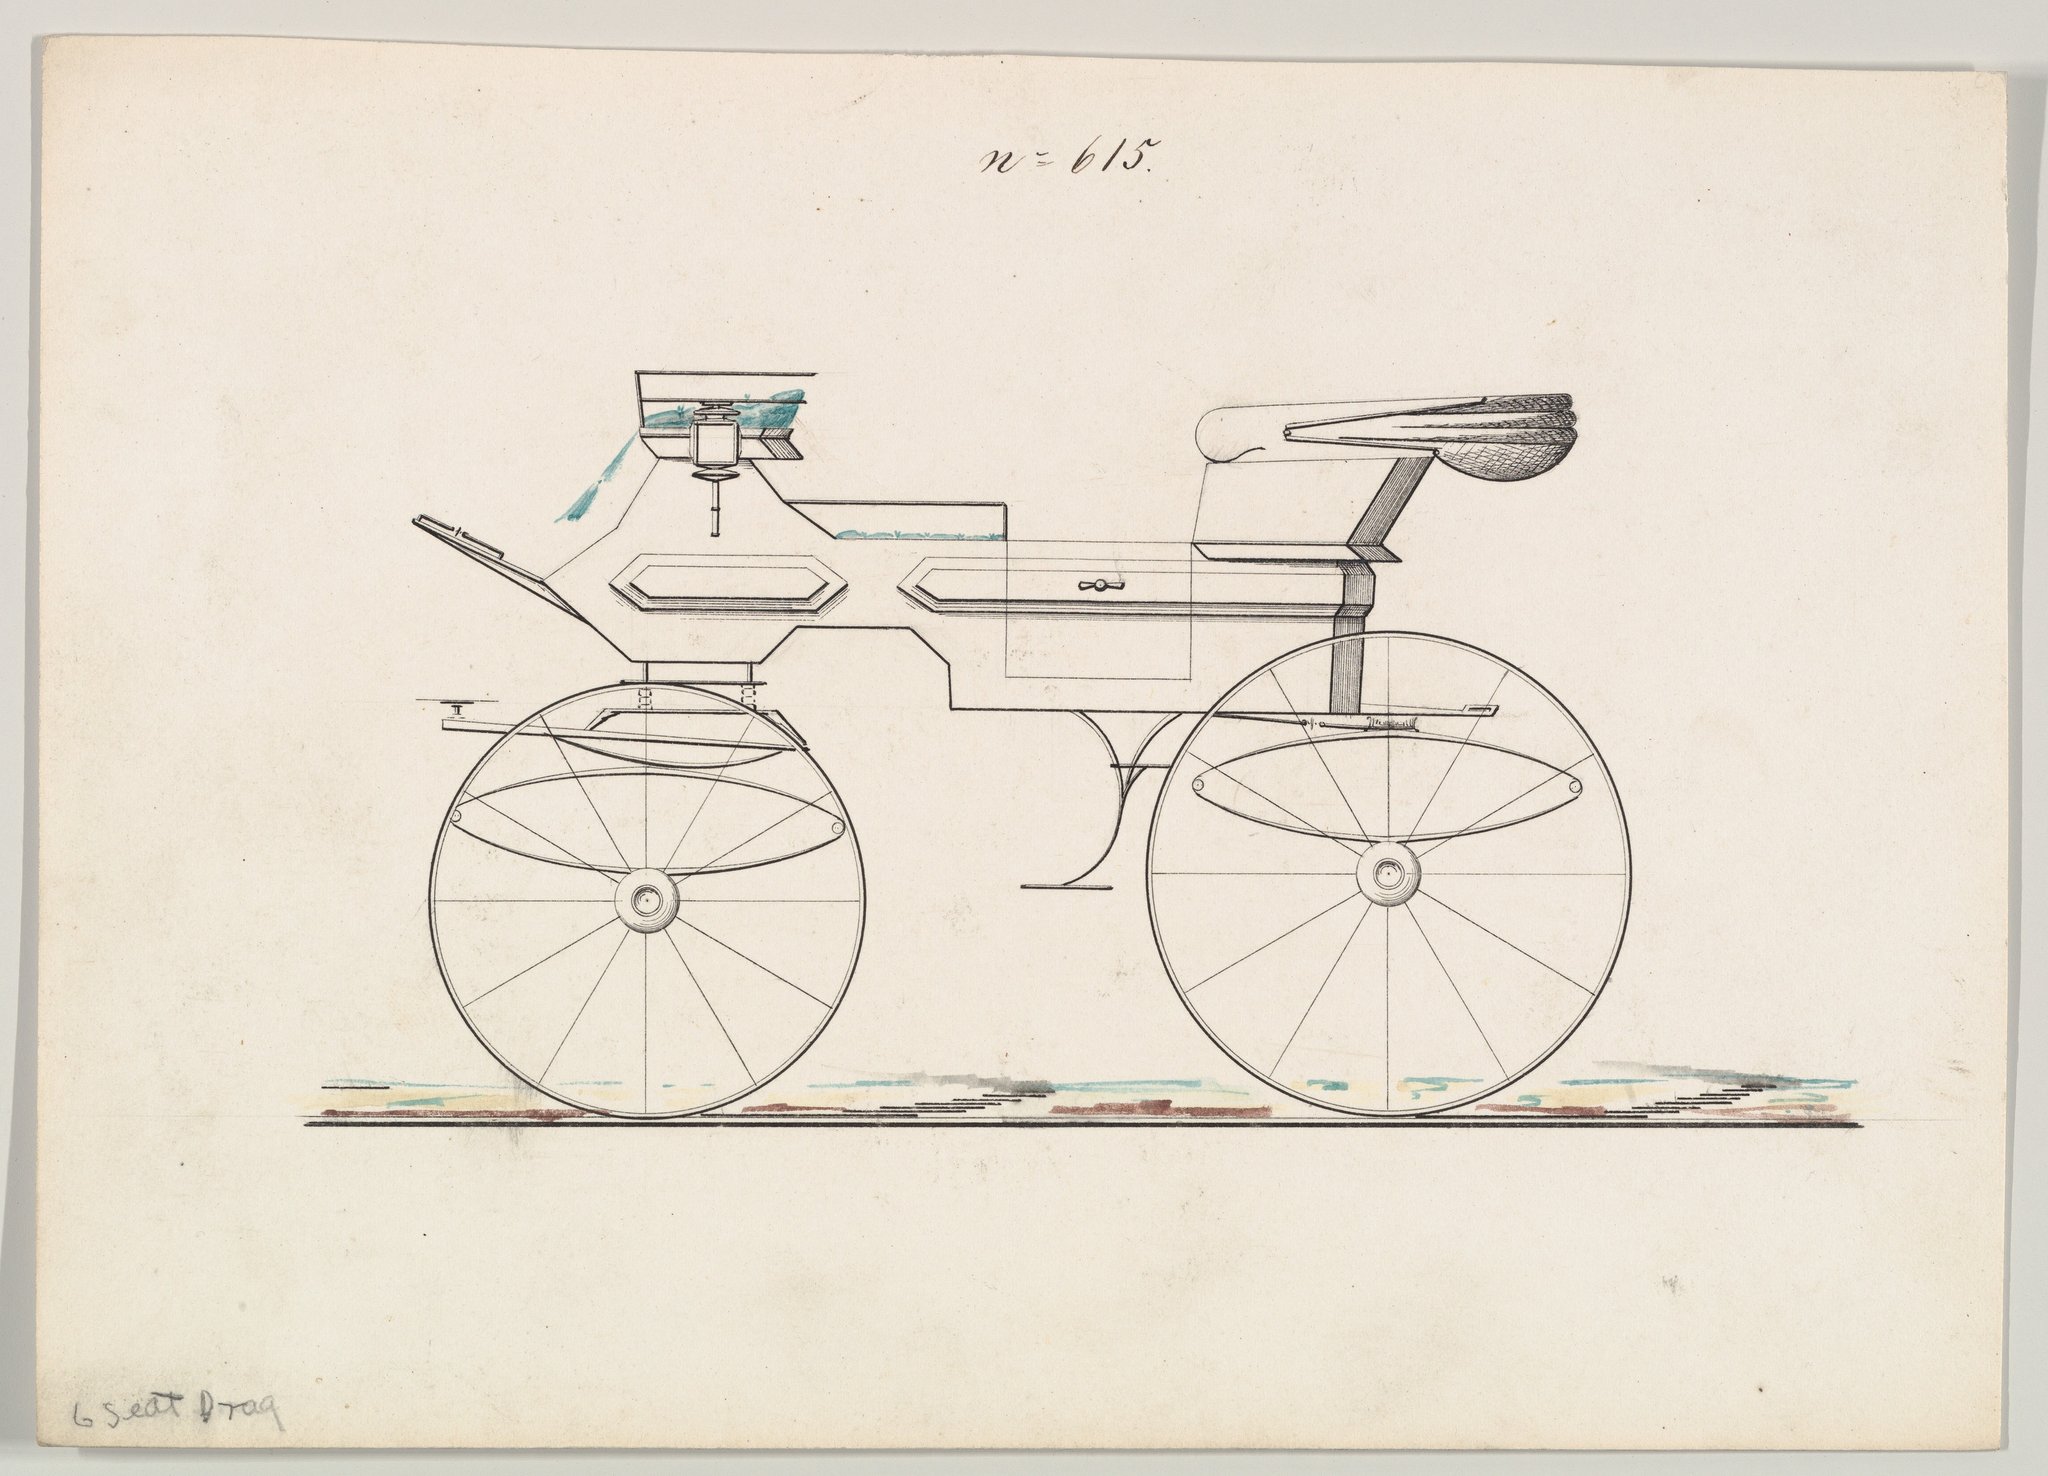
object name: drawing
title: Design for Vis-à-vis, no. 615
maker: brewster & co.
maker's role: manufacturer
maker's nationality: american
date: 1870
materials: gouache, graphite, ink, watercolor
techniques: pen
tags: carriages